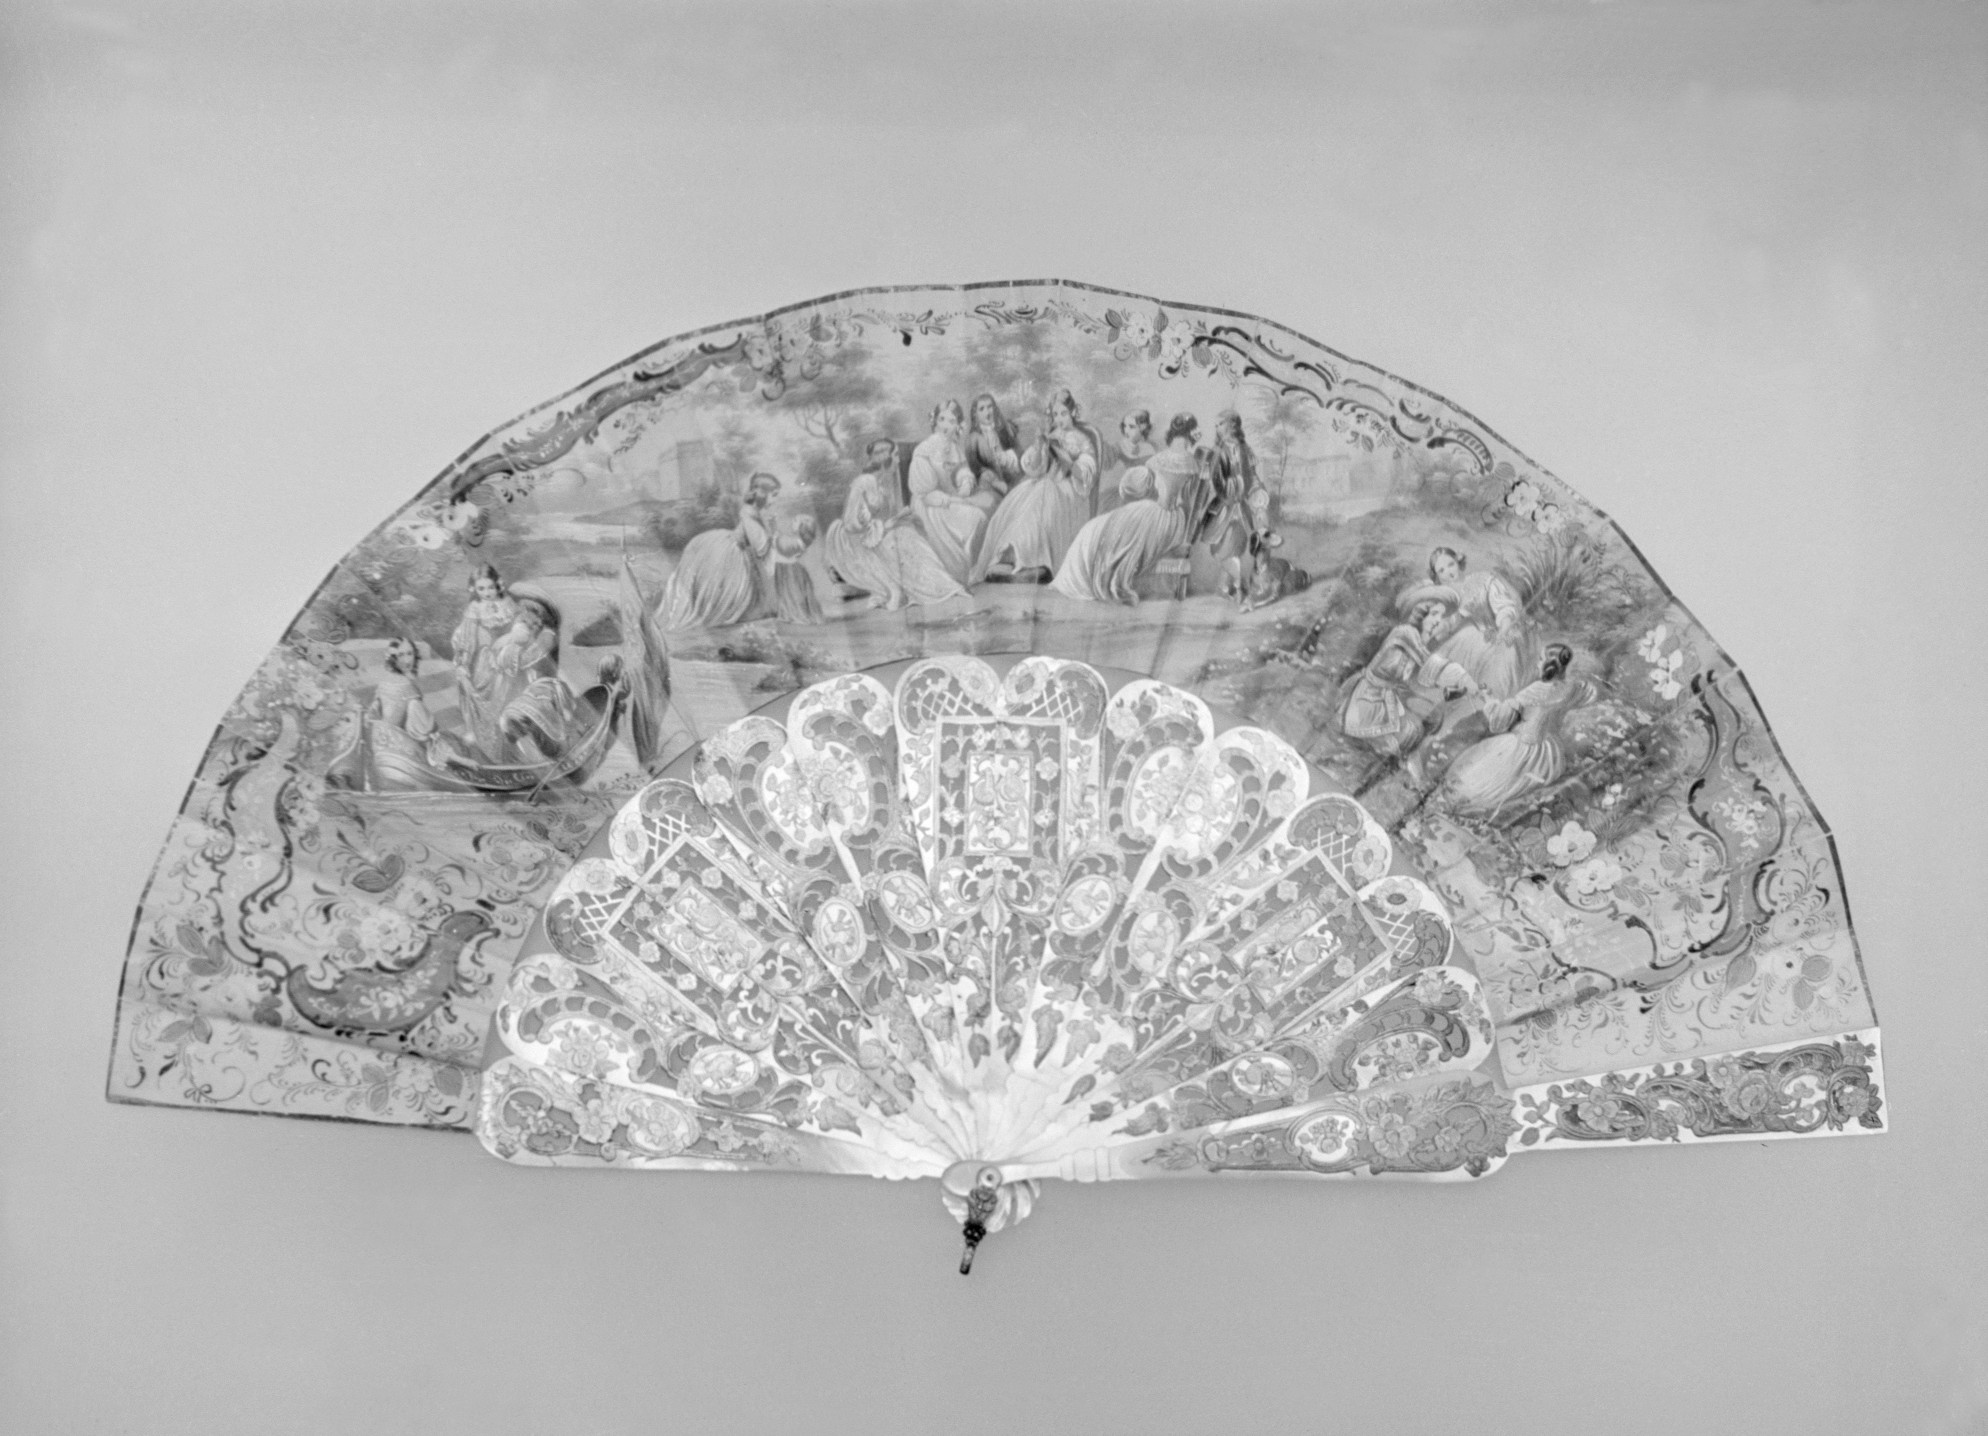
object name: fan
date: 1834-1866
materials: gilt, mother of pearl, parchment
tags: girls,women,dogs